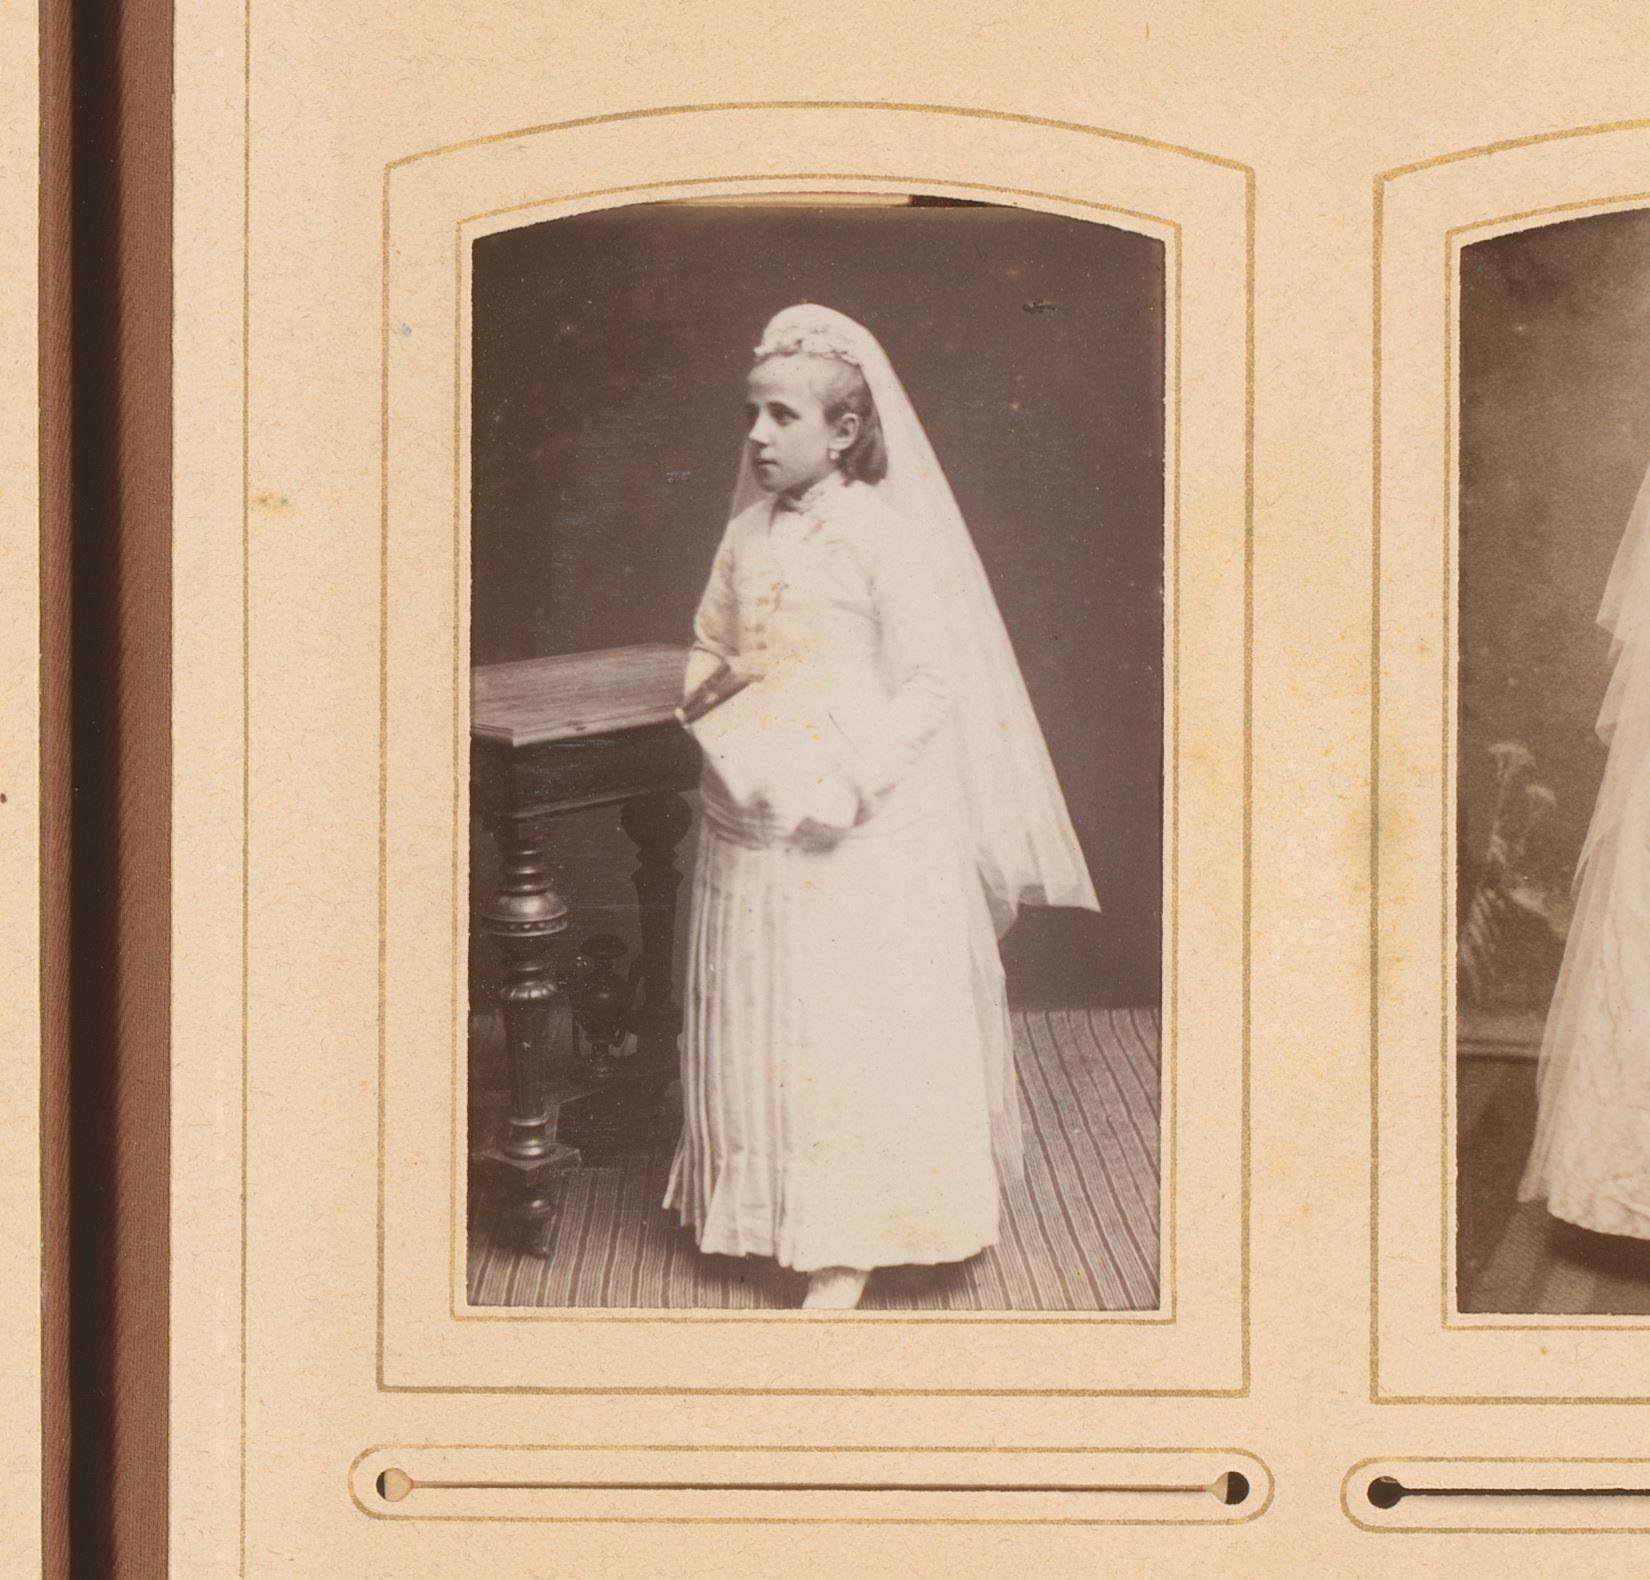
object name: carte de visite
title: Portret van een meisje in communiejurk, staand bij een tafel met boek in de hand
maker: hermanus jodocus weesing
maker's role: fotograaf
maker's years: 1844-1910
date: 1868-1900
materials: cardboard, photographic support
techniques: albumen print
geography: amsterdam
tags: historical persons - bb - woman, communion dress, girl (child between toddler and youth), table, book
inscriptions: inscription: ‘H. J. Weesing/ Photographe/ Amsterdam/ 1ste Atelier: Binnen Brouwerstraat 5./ 2de Atelier: Hoogte Kadijk 87./ Nabestellingen en Vergrootingen’